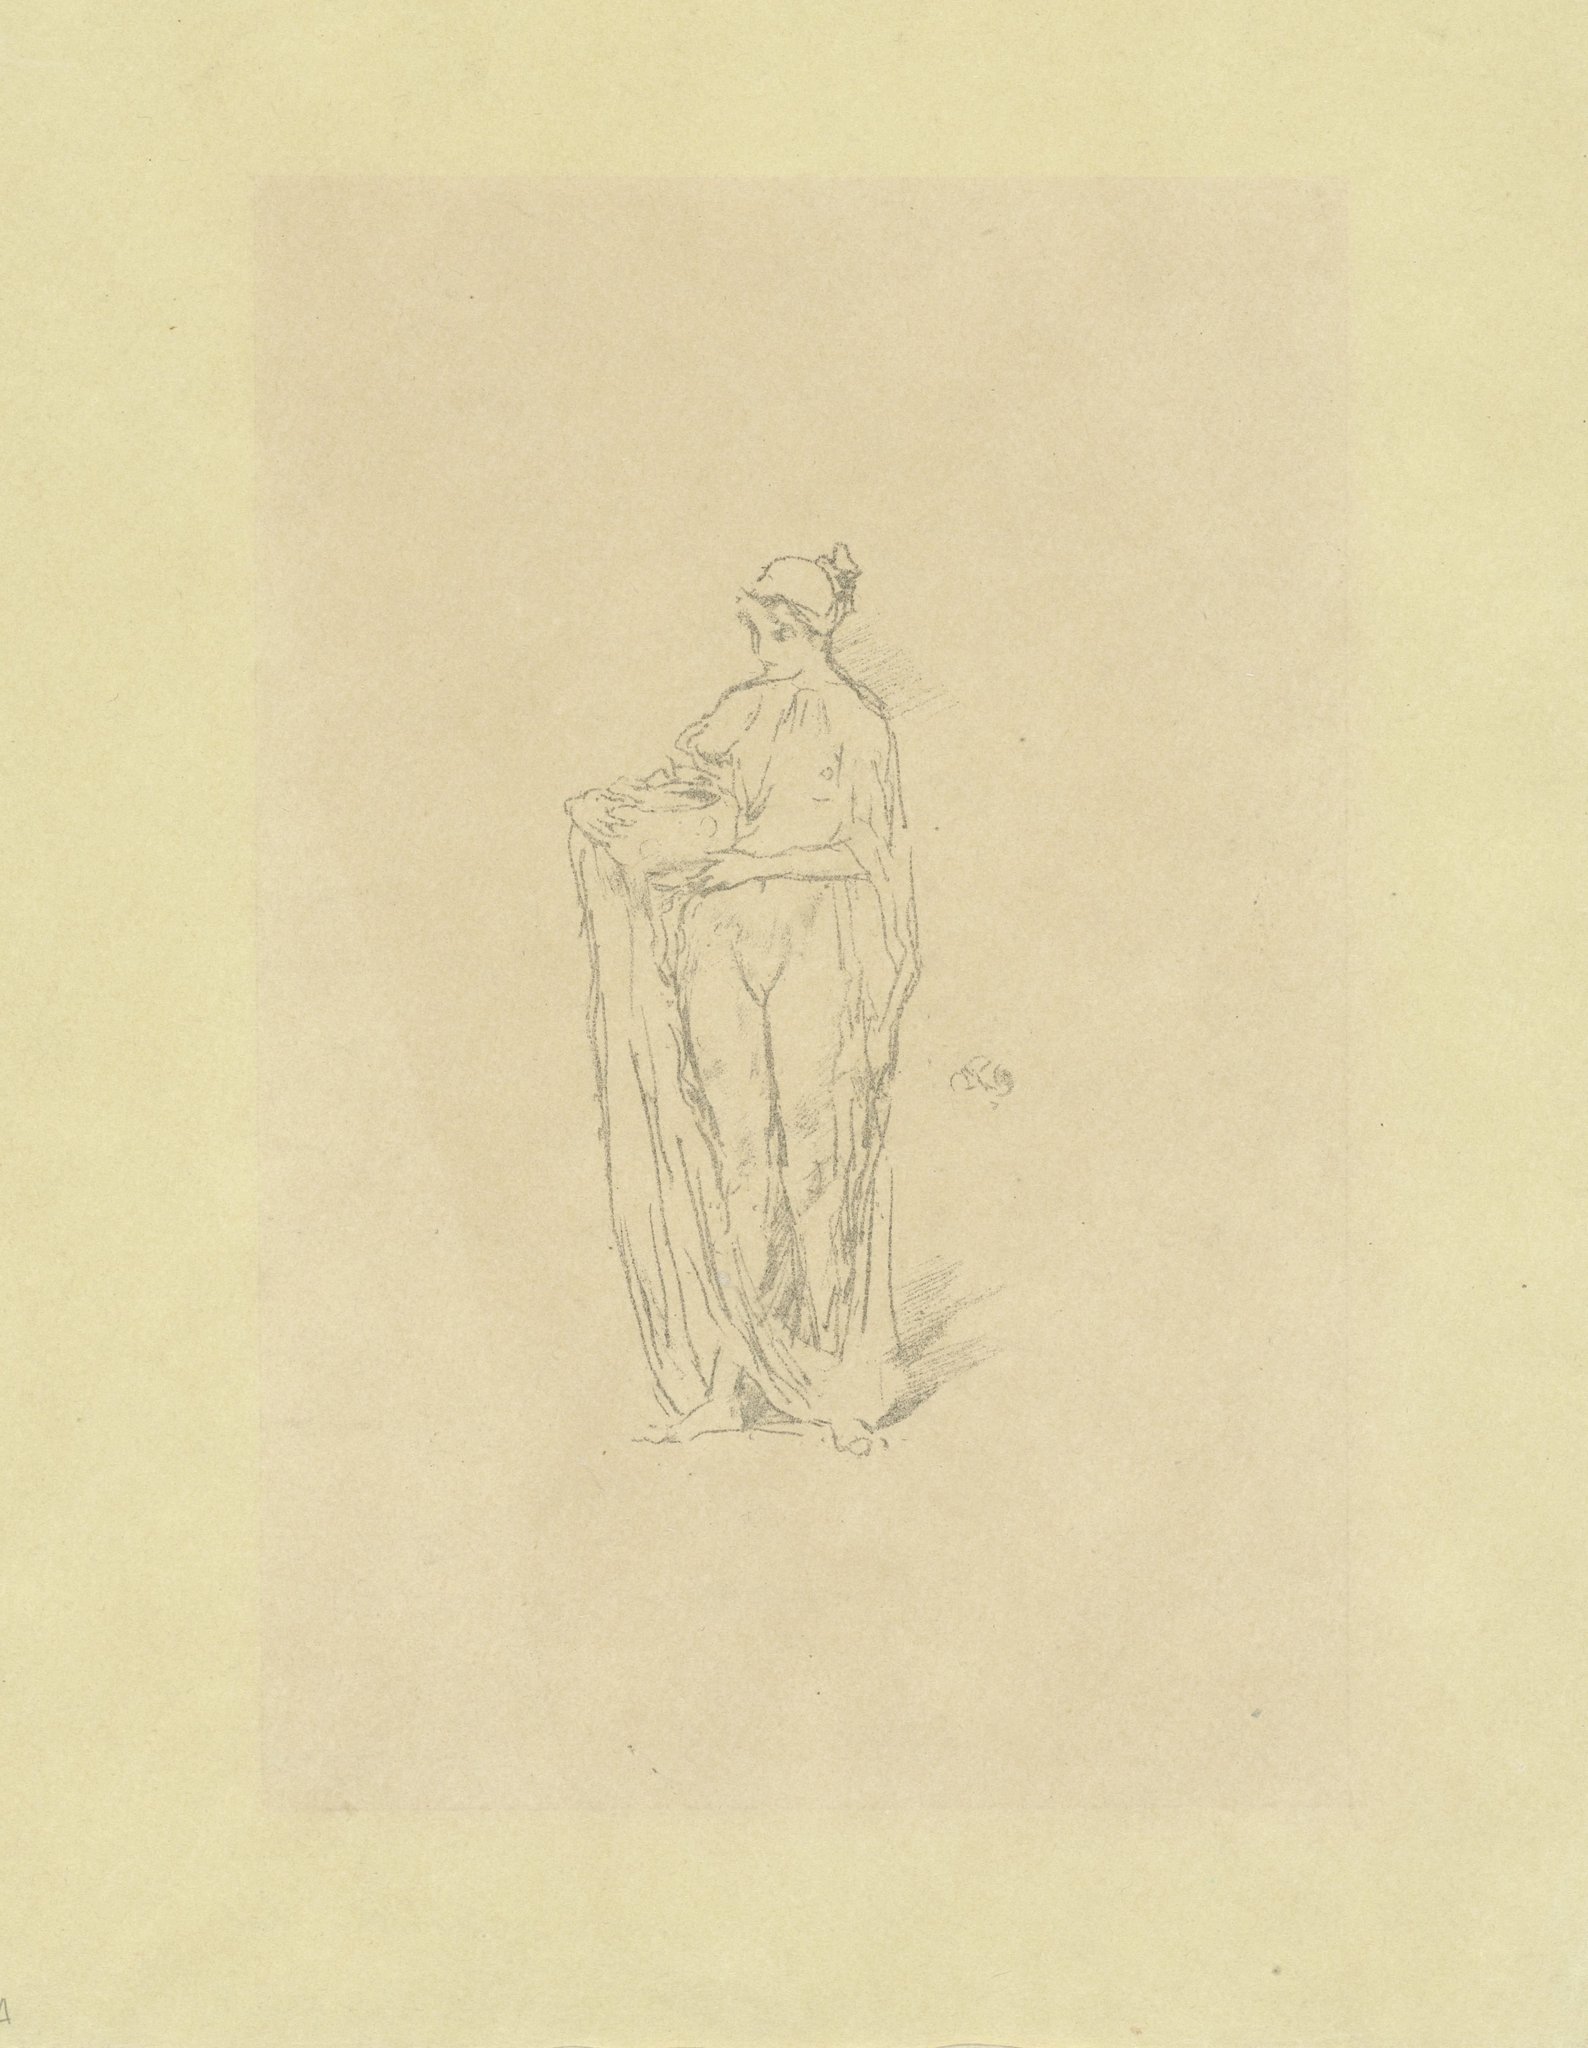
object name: print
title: Girl with Bowl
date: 1895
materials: paper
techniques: lithograph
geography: london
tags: the (nude) human figure; 'corpo humano' (ripa) (+ old female (human being))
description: Jonge vrouw, bijna geheel naakt, staand met een schaal in haar handen en een doek over haar schouders.